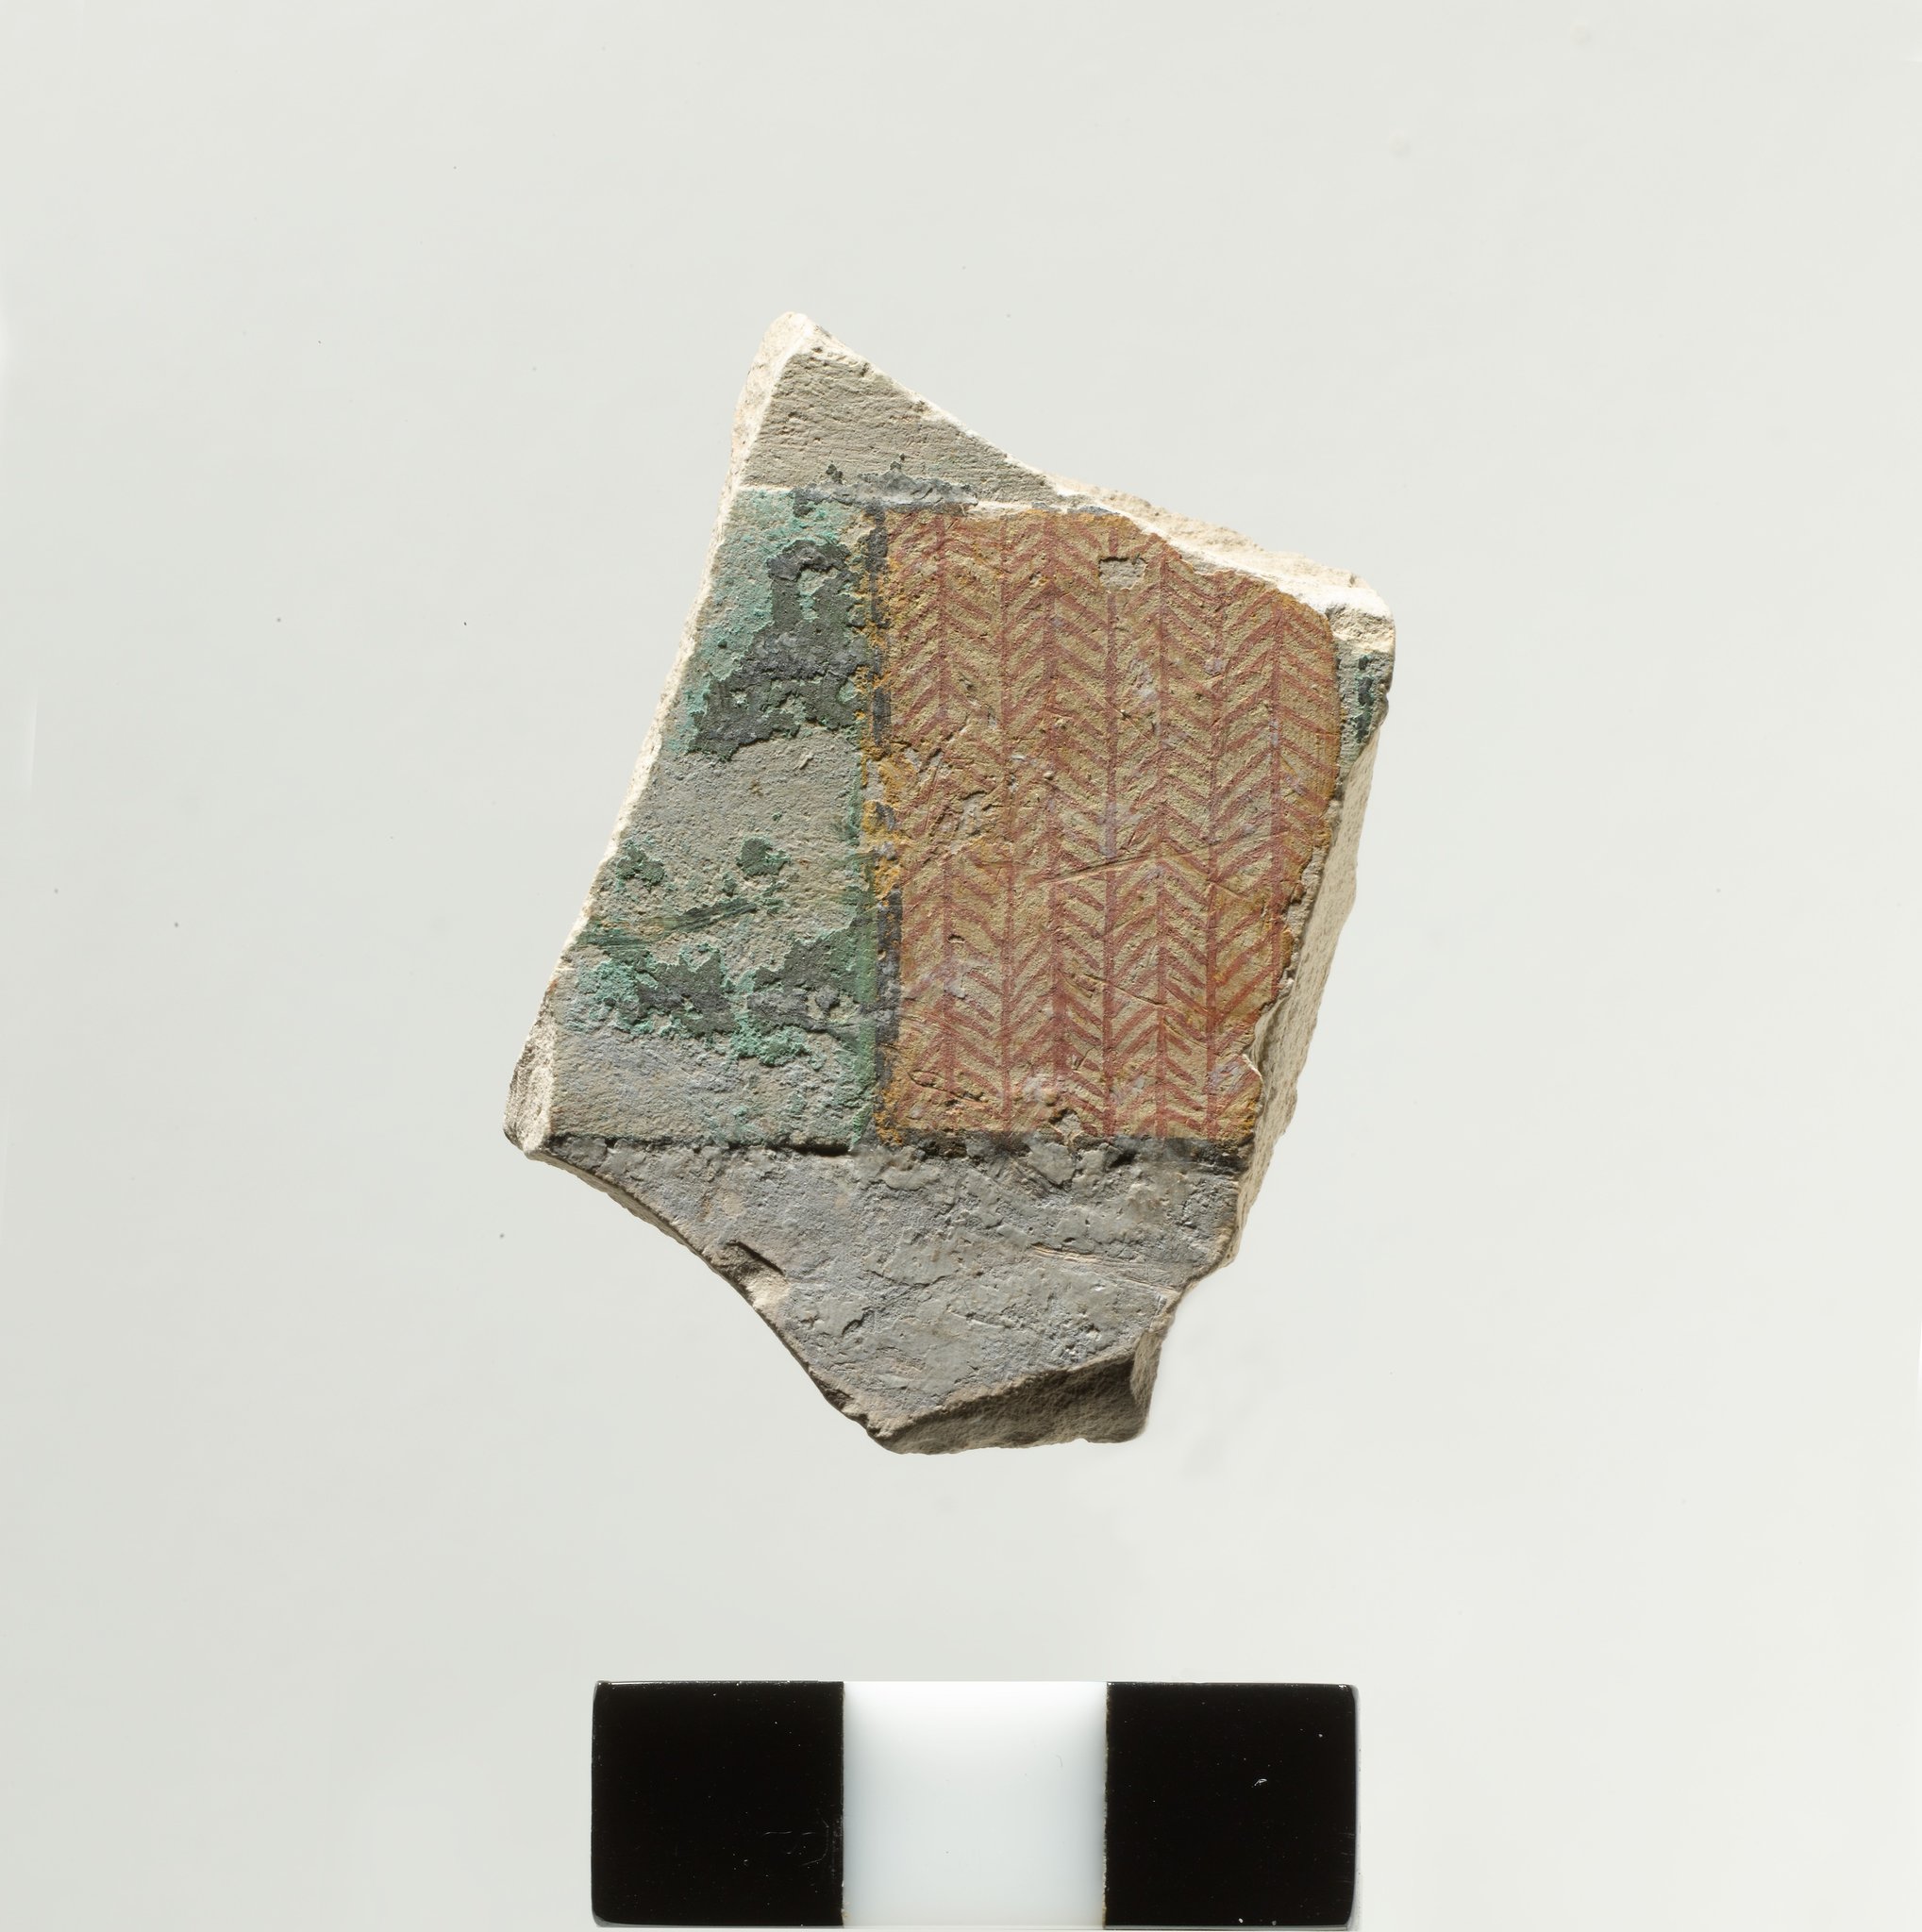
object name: relief fragment, tomb of meketre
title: Relief fragment from the tomb of Meketre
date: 1981-1975 BCE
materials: limestone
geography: egypt